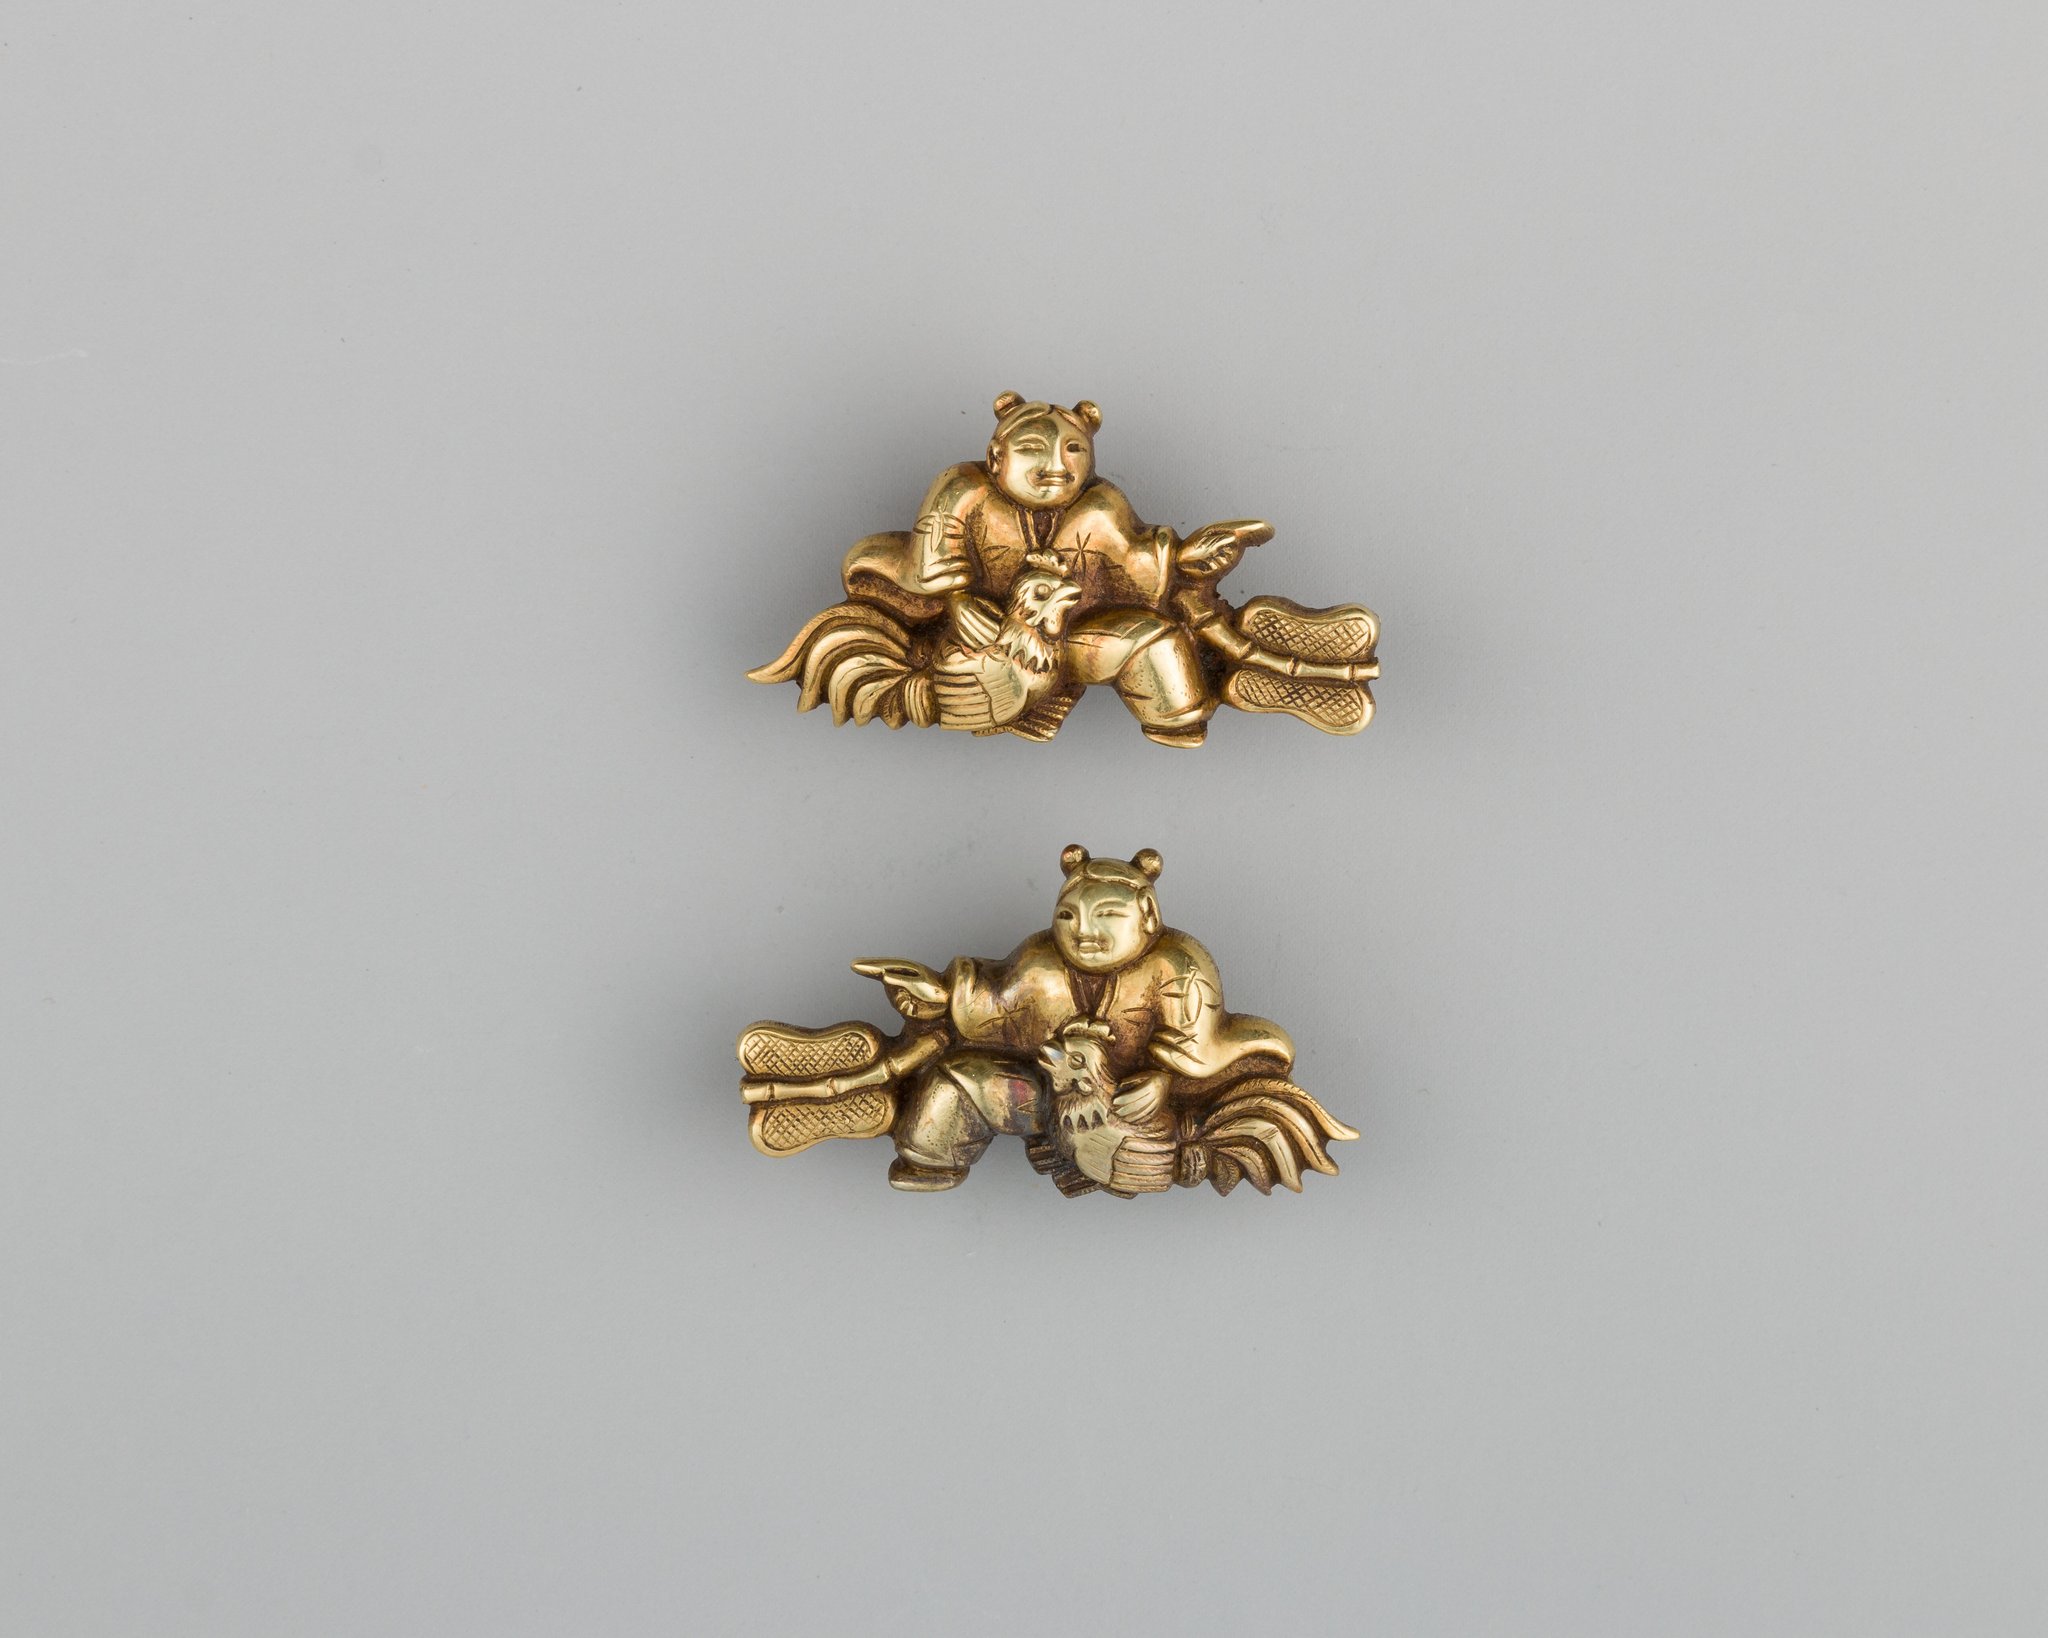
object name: pair of sword grip ornament menuki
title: Pair of Sword-Grip Ornaments (Menuki)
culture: japanese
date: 1701-1800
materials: gold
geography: japan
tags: human figures